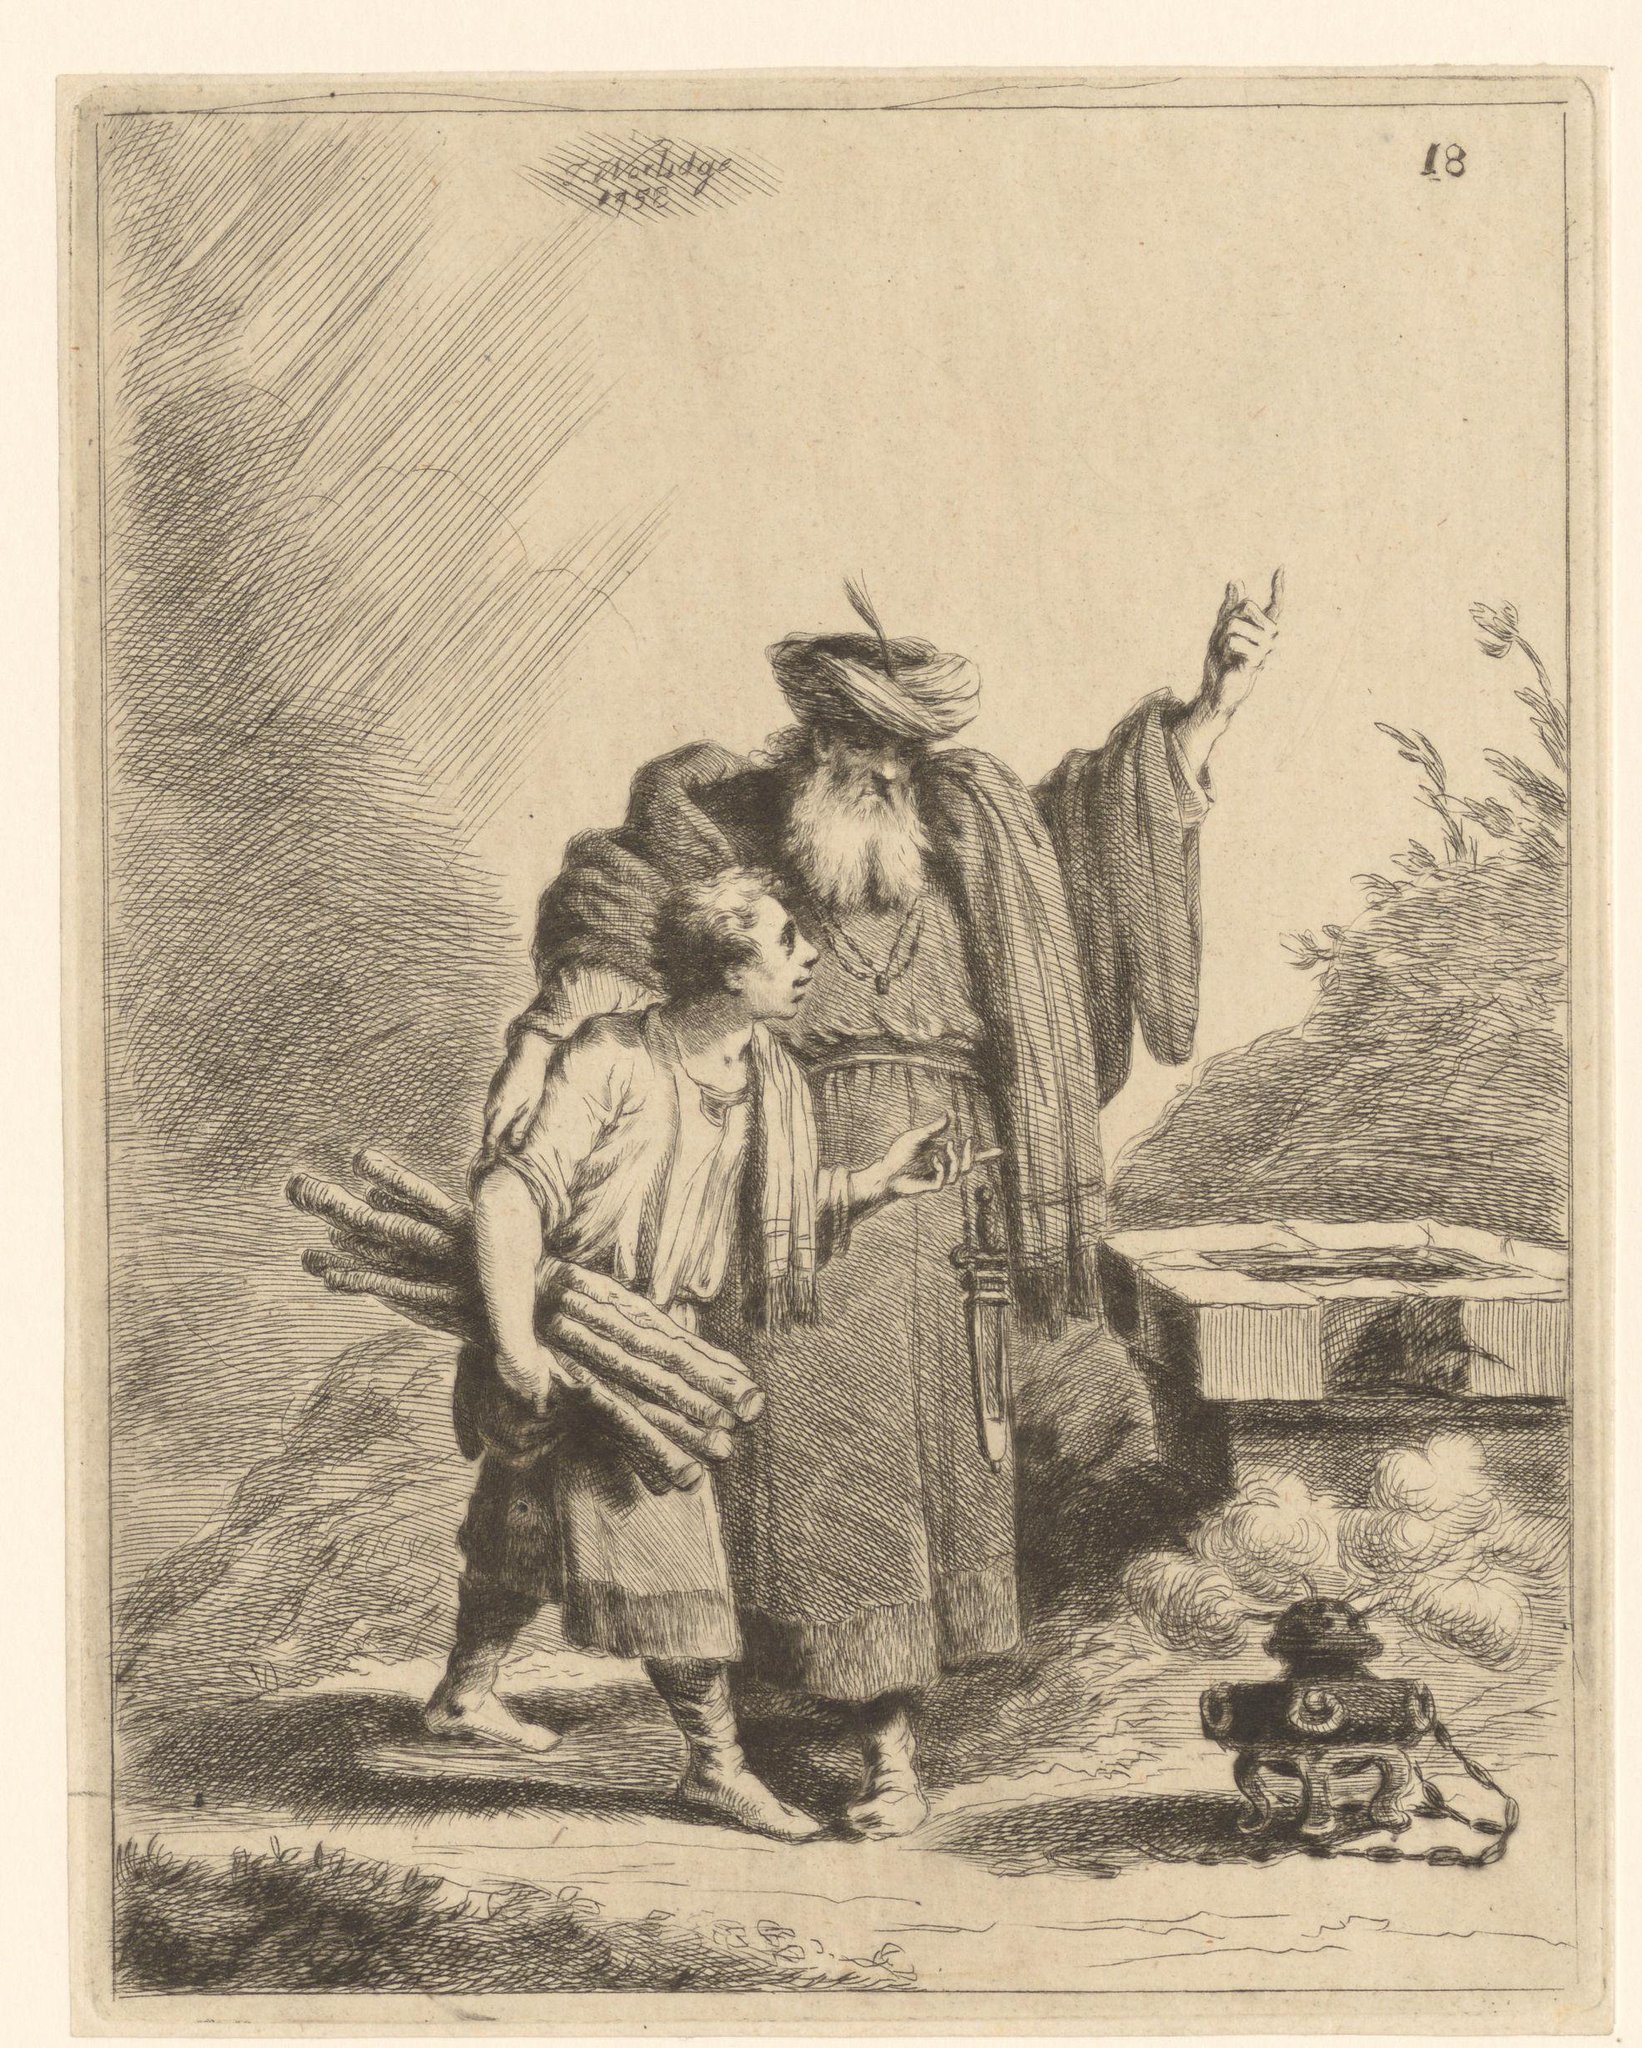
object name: print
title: Abraham en Isaak bij de offerplaats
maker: thomas worlidge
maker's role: print maker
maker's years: 1700-1766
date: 1758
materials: paper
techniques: drypoint, etching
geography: london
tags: the sacrifice of isaac (genesis 22)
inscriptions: collector's mark: Lugt 240